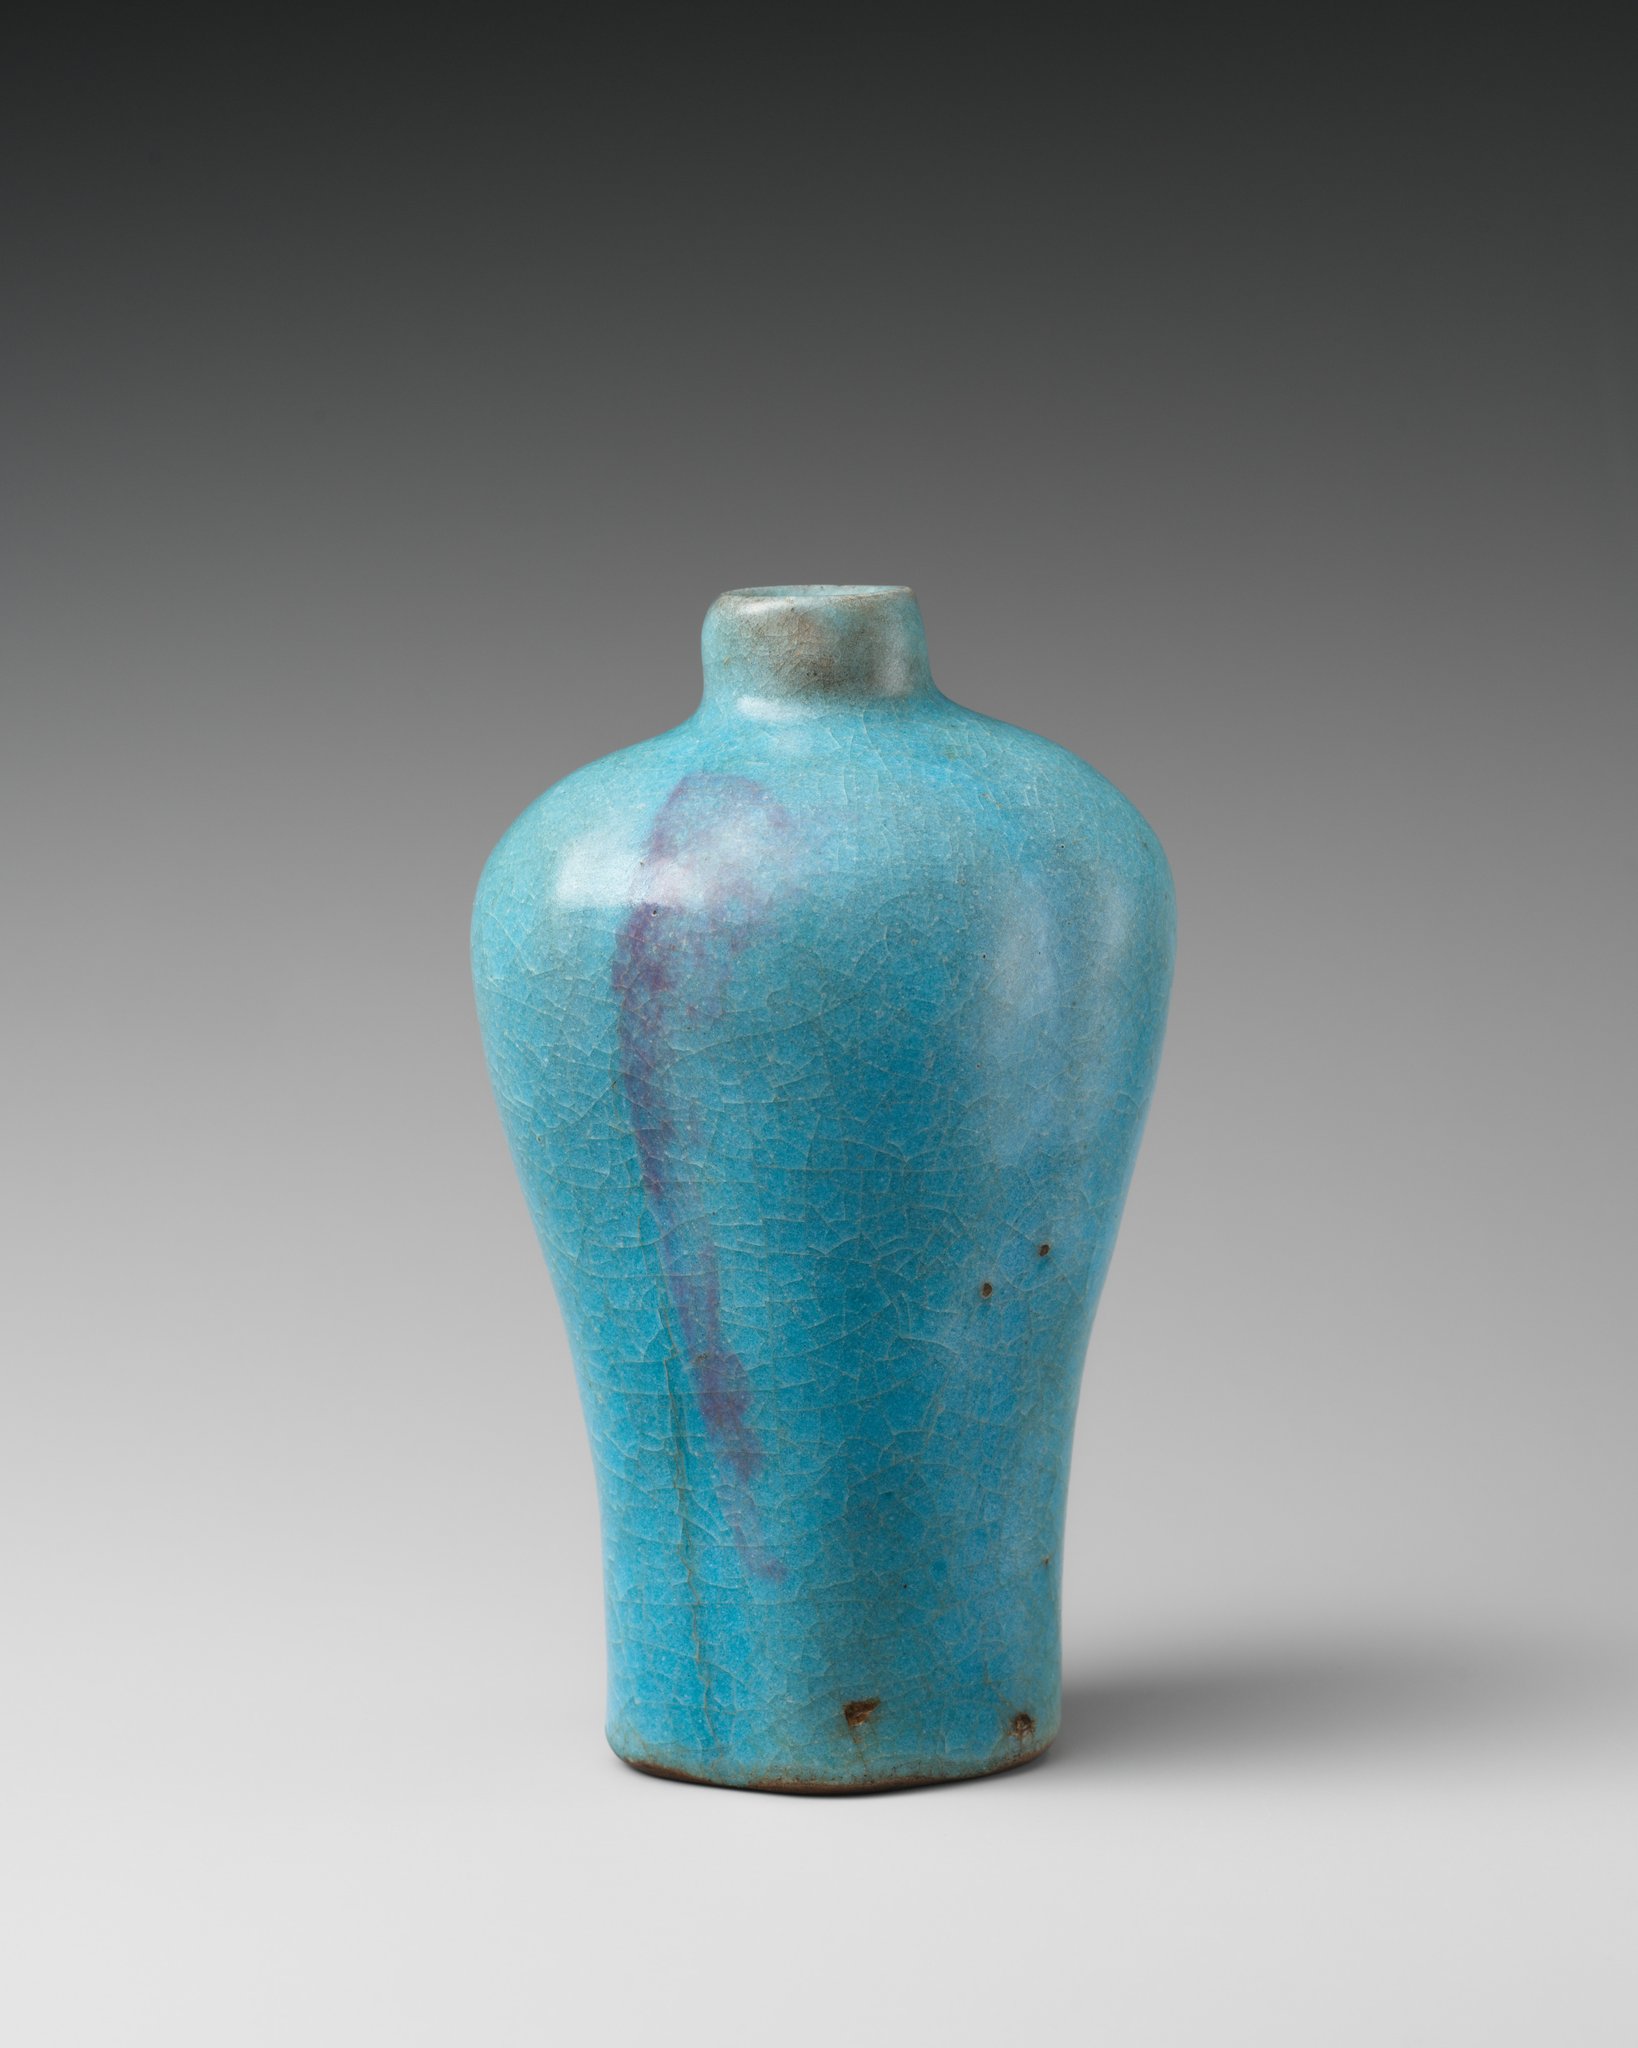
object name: vase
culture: chinese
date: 1801-1900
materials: glaze, stoneware